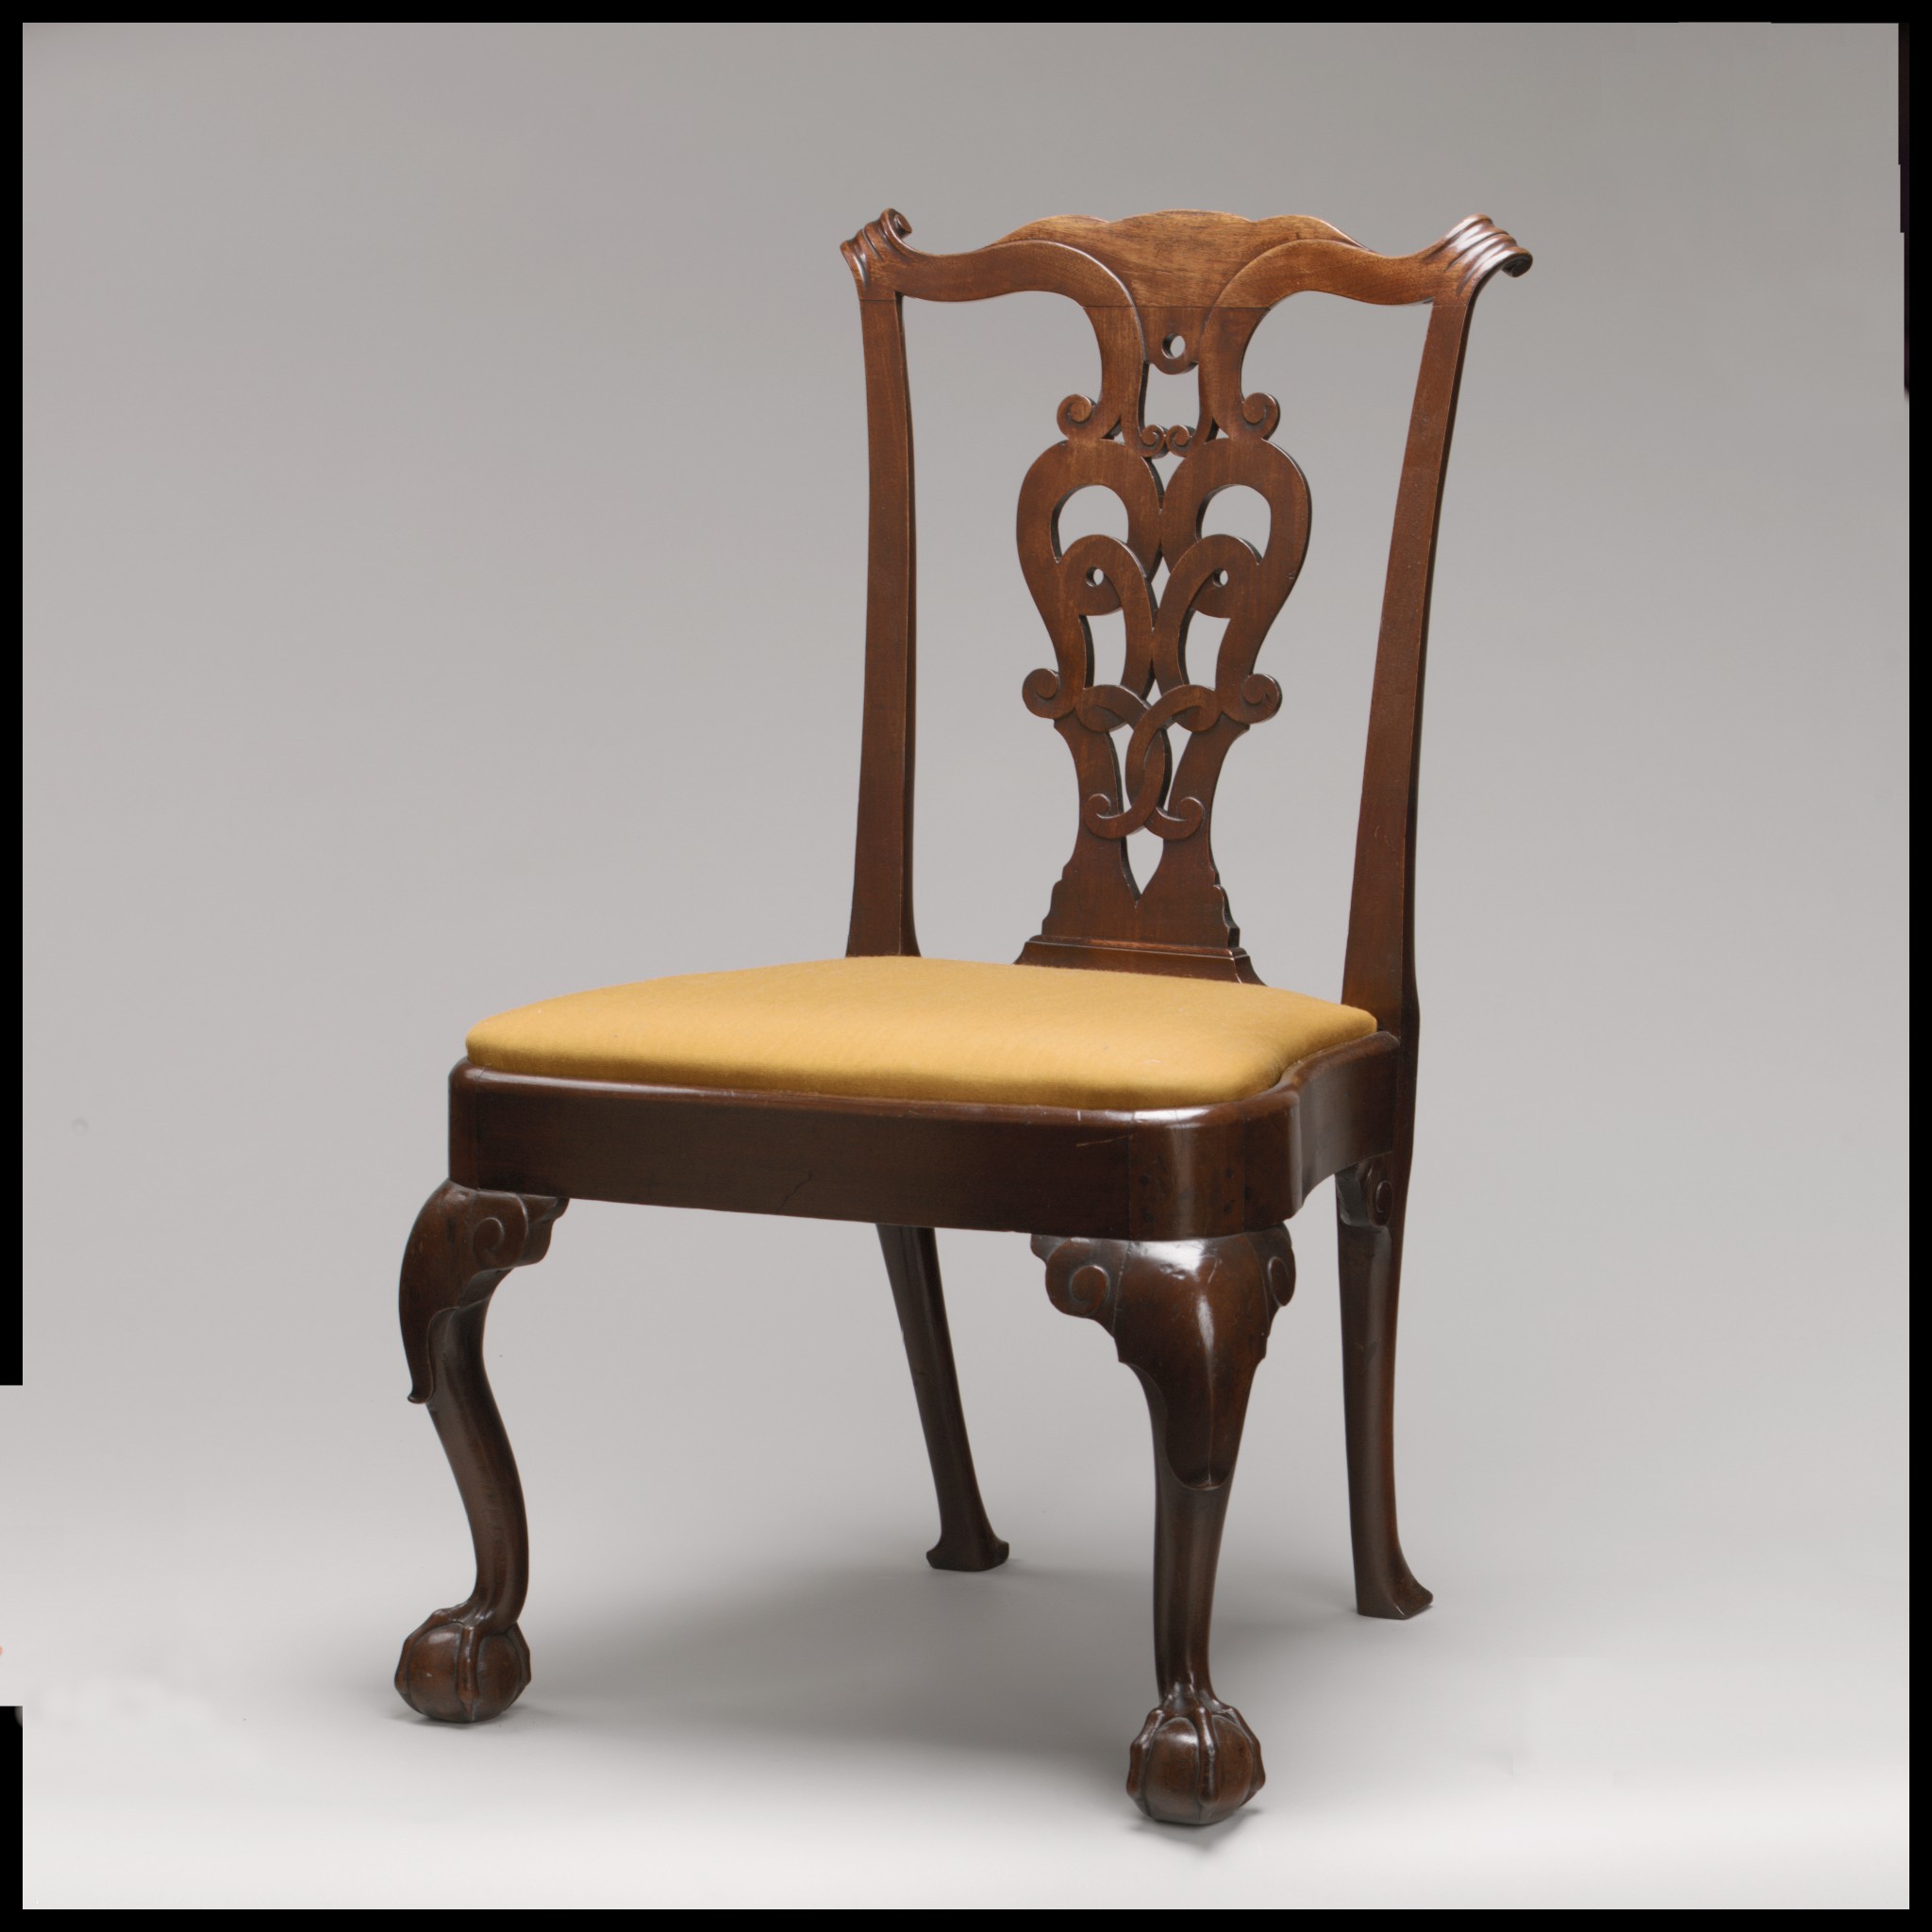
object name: side chair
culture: american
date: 1760-1790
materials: wood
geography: united states